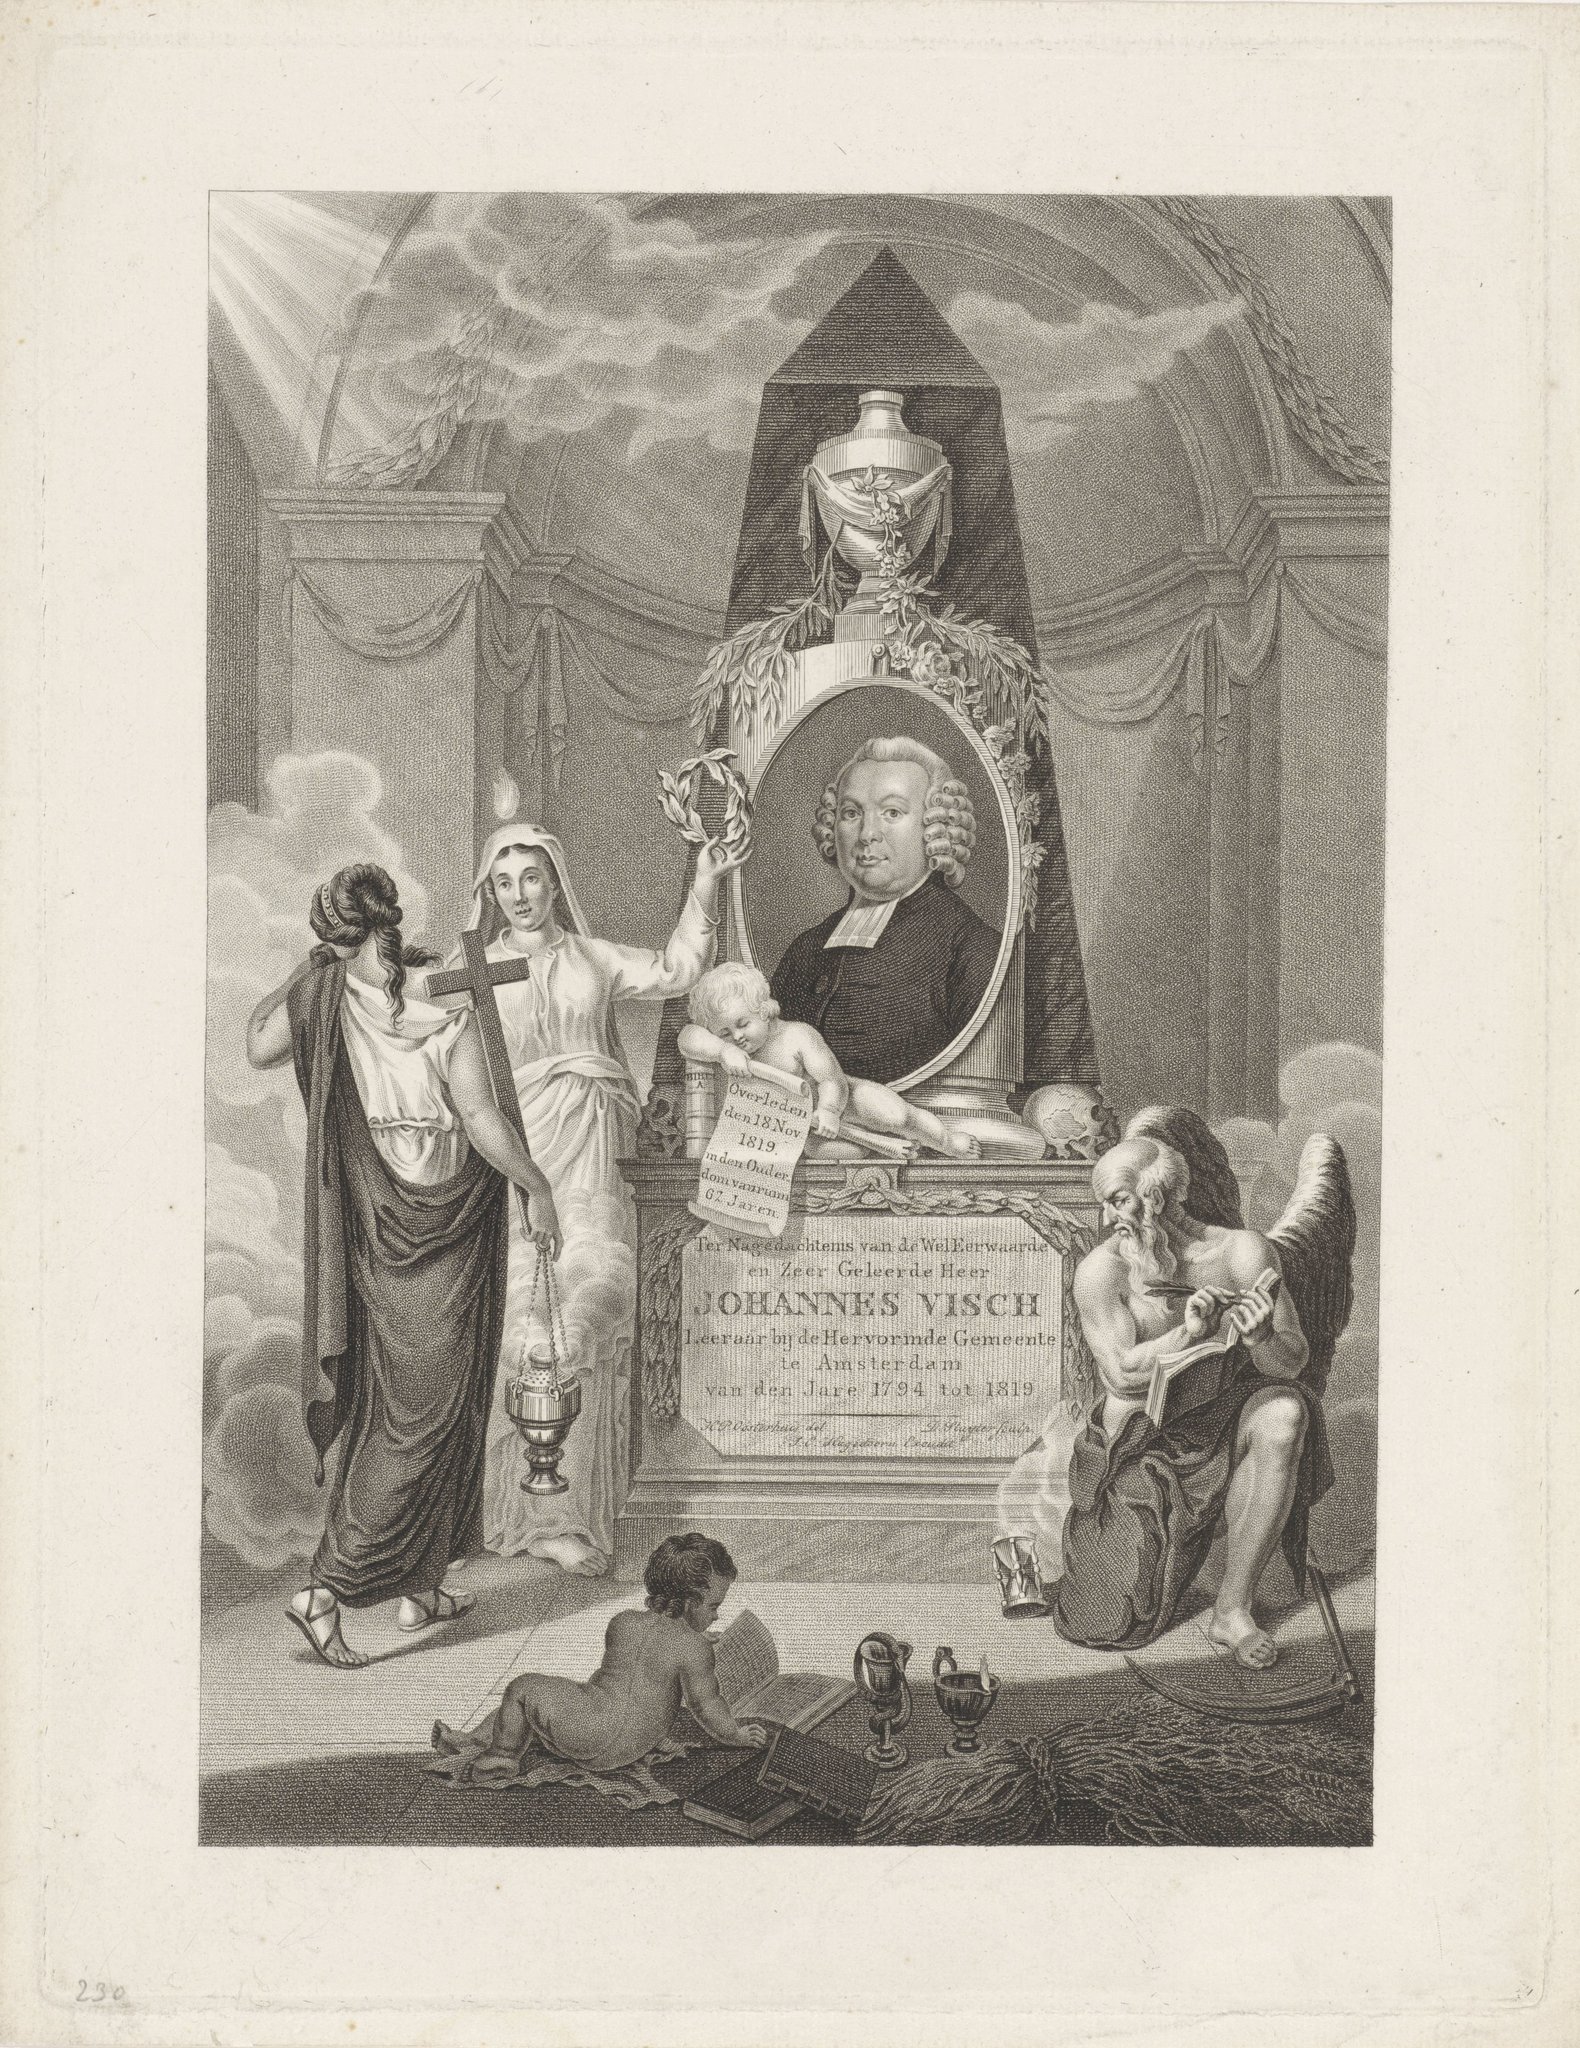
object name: print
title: Allegorische voorstelling met het portret van Johannes Visch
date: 1819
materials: paper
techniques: engraving, etching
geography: amsterdam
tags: utrecht, amsterdam, fugacity of time, grave-building, monumental tomb, father time, man with wings and scythe, allegories and personifications ~ protestantism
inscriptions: collector's mark: Lugt 2228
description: Grafmonument met daarop het portret van de Amsterdamse predikant Johannes Visch. Het portret wordt geflankeerd door een schedel en een bijbel, waarop een slapende putto steunt. Deze houdt een een gedoofde fakkel vast en een papier met daarop de overlijdensdatum. Eronder een opschrift met Visch' naam, functie, zijn gemeente en de jaren waarin hij daar werkzaam was. Naast het monument staan Geloof, met kruis en wierookvat, en Godsdienst. Vadertje Tijd zit geknield naast het monument, schrijvend in een boek. Op de voorgrond zit een putto met boeken, een door een slang omslingerde beker, een brandende lamp en een korenschoof.